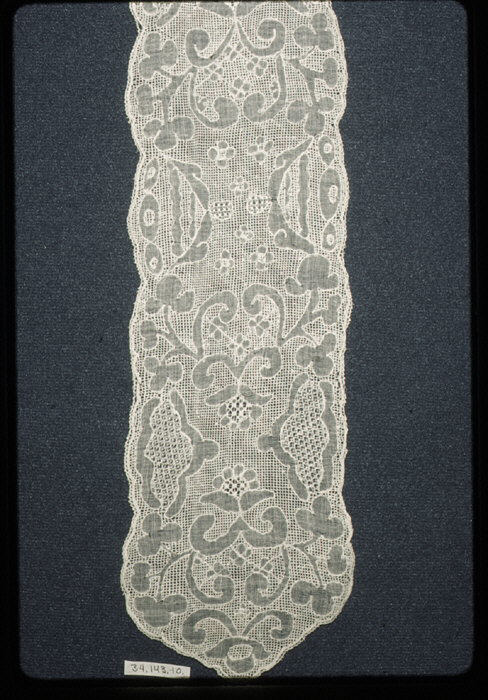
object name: lappet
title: Lappet (one of a pair)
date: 1701-1800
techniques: embroidery